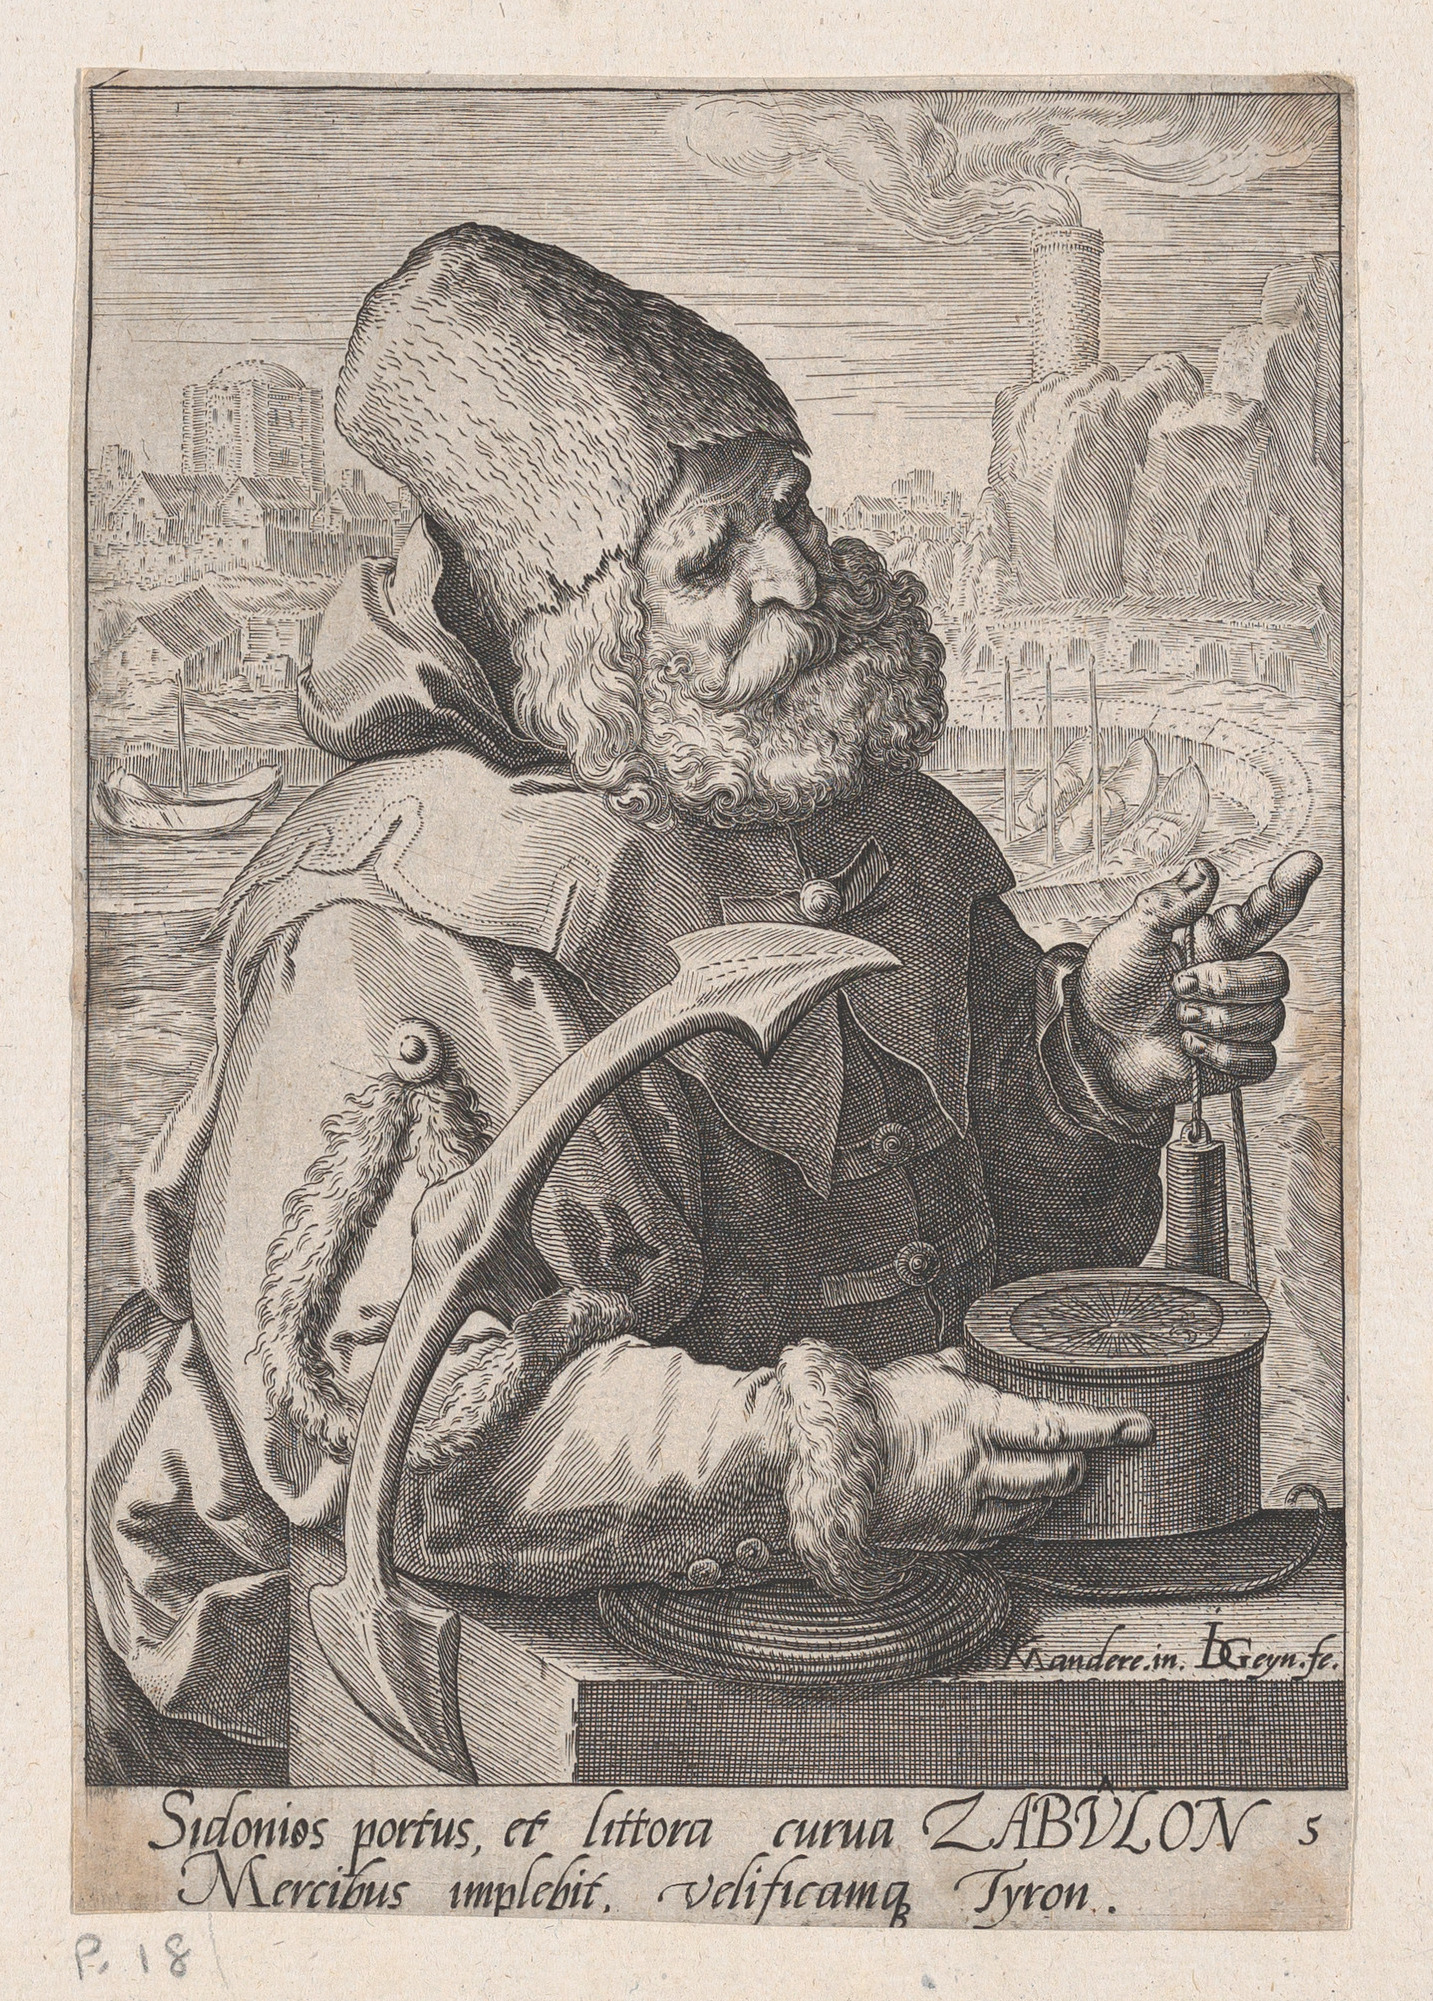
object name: print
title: Zebulon, from "The Twelve Sons of Jacob"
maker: jacques de gheyn (ii)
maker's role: artist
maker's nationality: netherlandish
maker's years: 1565-1629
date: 1584-1594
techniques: engraving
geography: amsterdam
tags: men,portraits